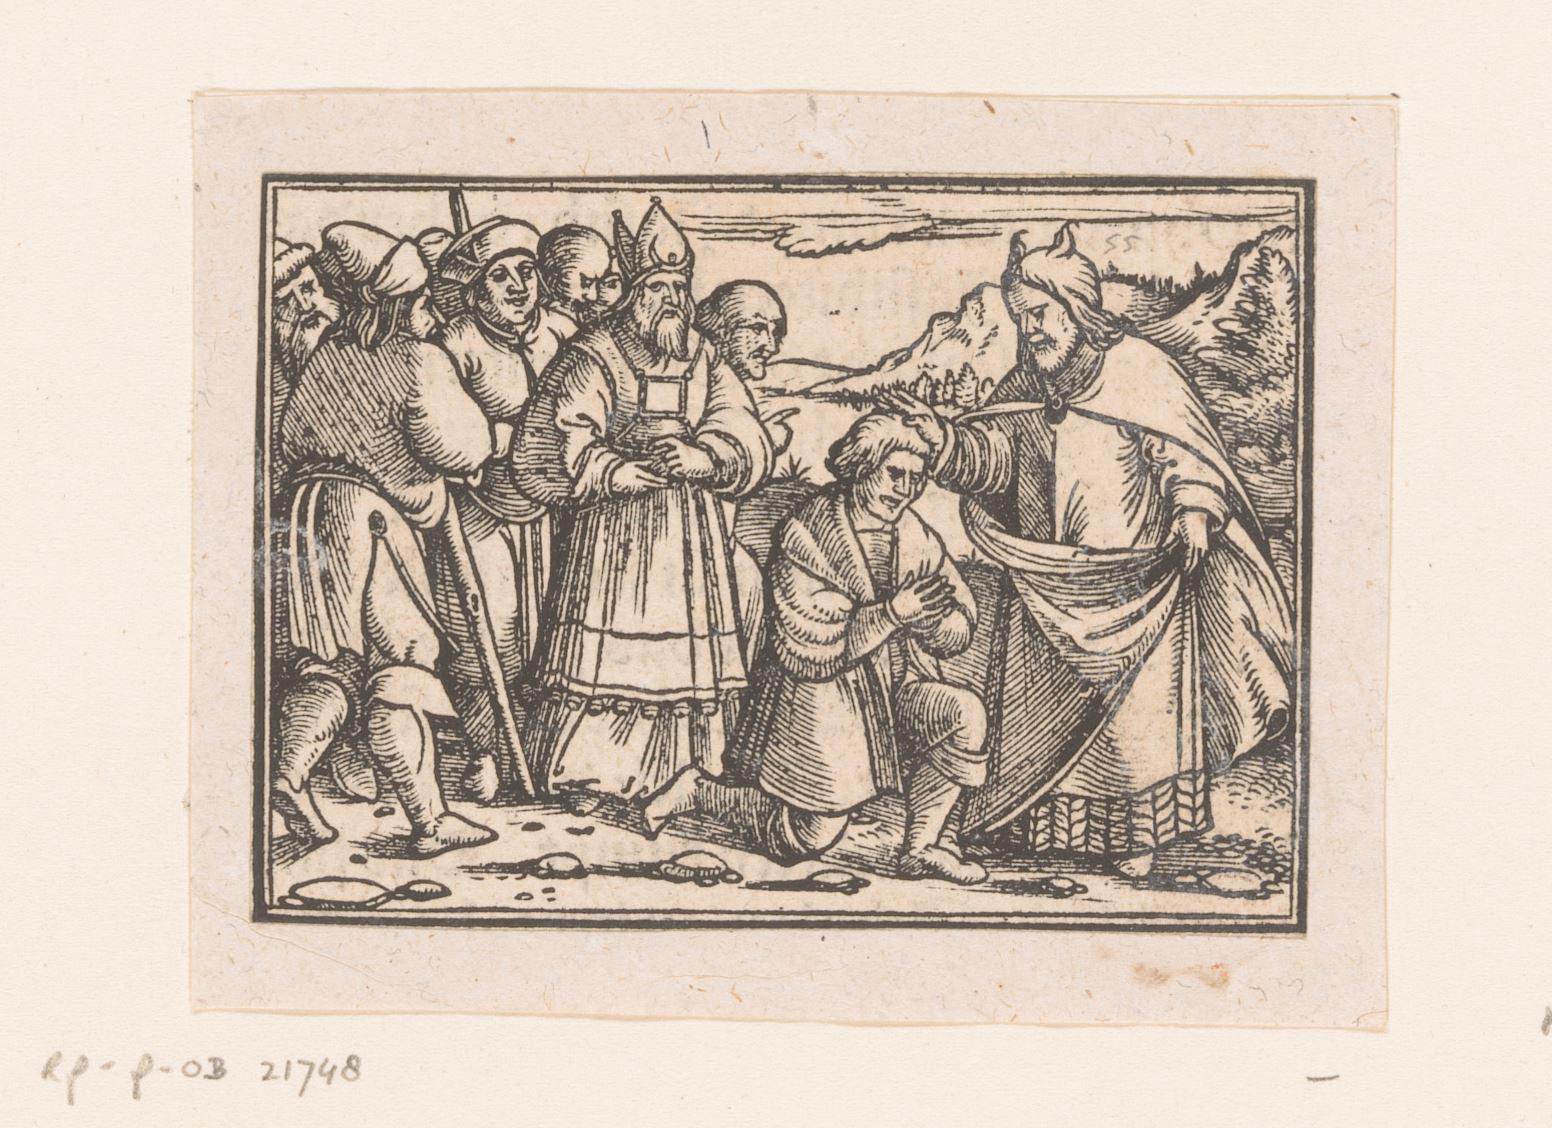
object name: print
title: Mozes zegent een geknielde man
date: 1522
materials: paper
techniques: woodcut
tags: the book exodus: story of moses and aaron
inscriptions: collector's mark: Lugt 240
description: Mogelijk een kopie van een prent van Hans Holbein de jongere. Niet uit de Icones historiarum Veteris Testamenti van 1538. Deze kopie mogelijk uit: Biblia sacra iuxta vulgatam. Parijs: Jean Benoît, 1552. Ook aanwezig in de Herzog August Bibliothek: http://diglib.hab.de?grafik=graph-res-d-326-1.